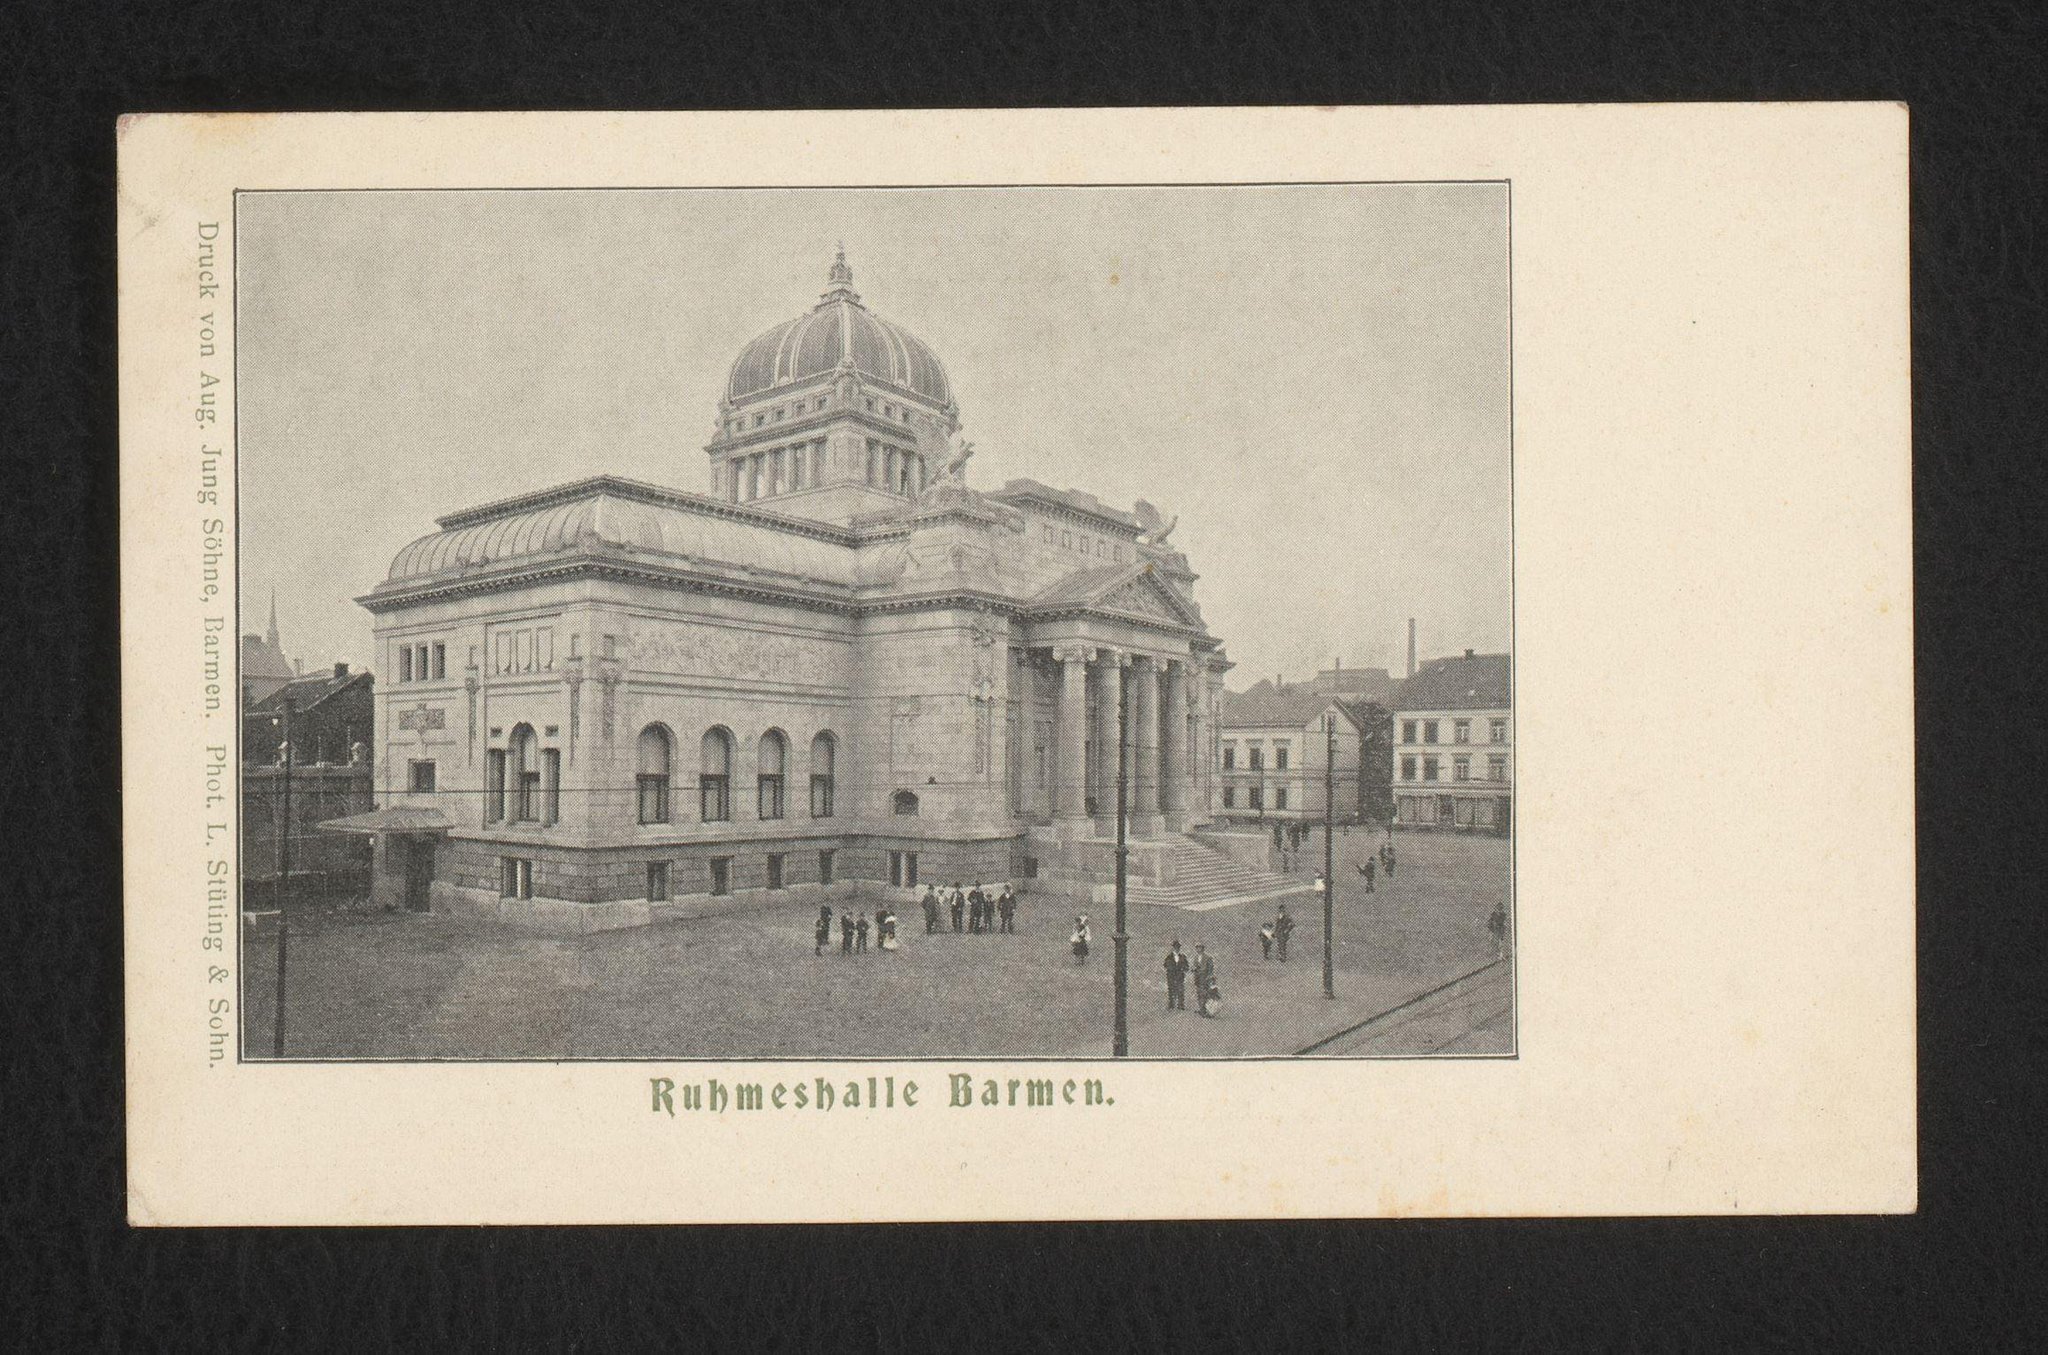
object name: ansichtkaart, prentbriefkaart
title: Rumeshalle Barmen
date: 1881-1910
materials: cardboard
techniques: autotype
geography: barmen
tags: favourable reputation; artistic fame, edifice, e.g.: public building, department store